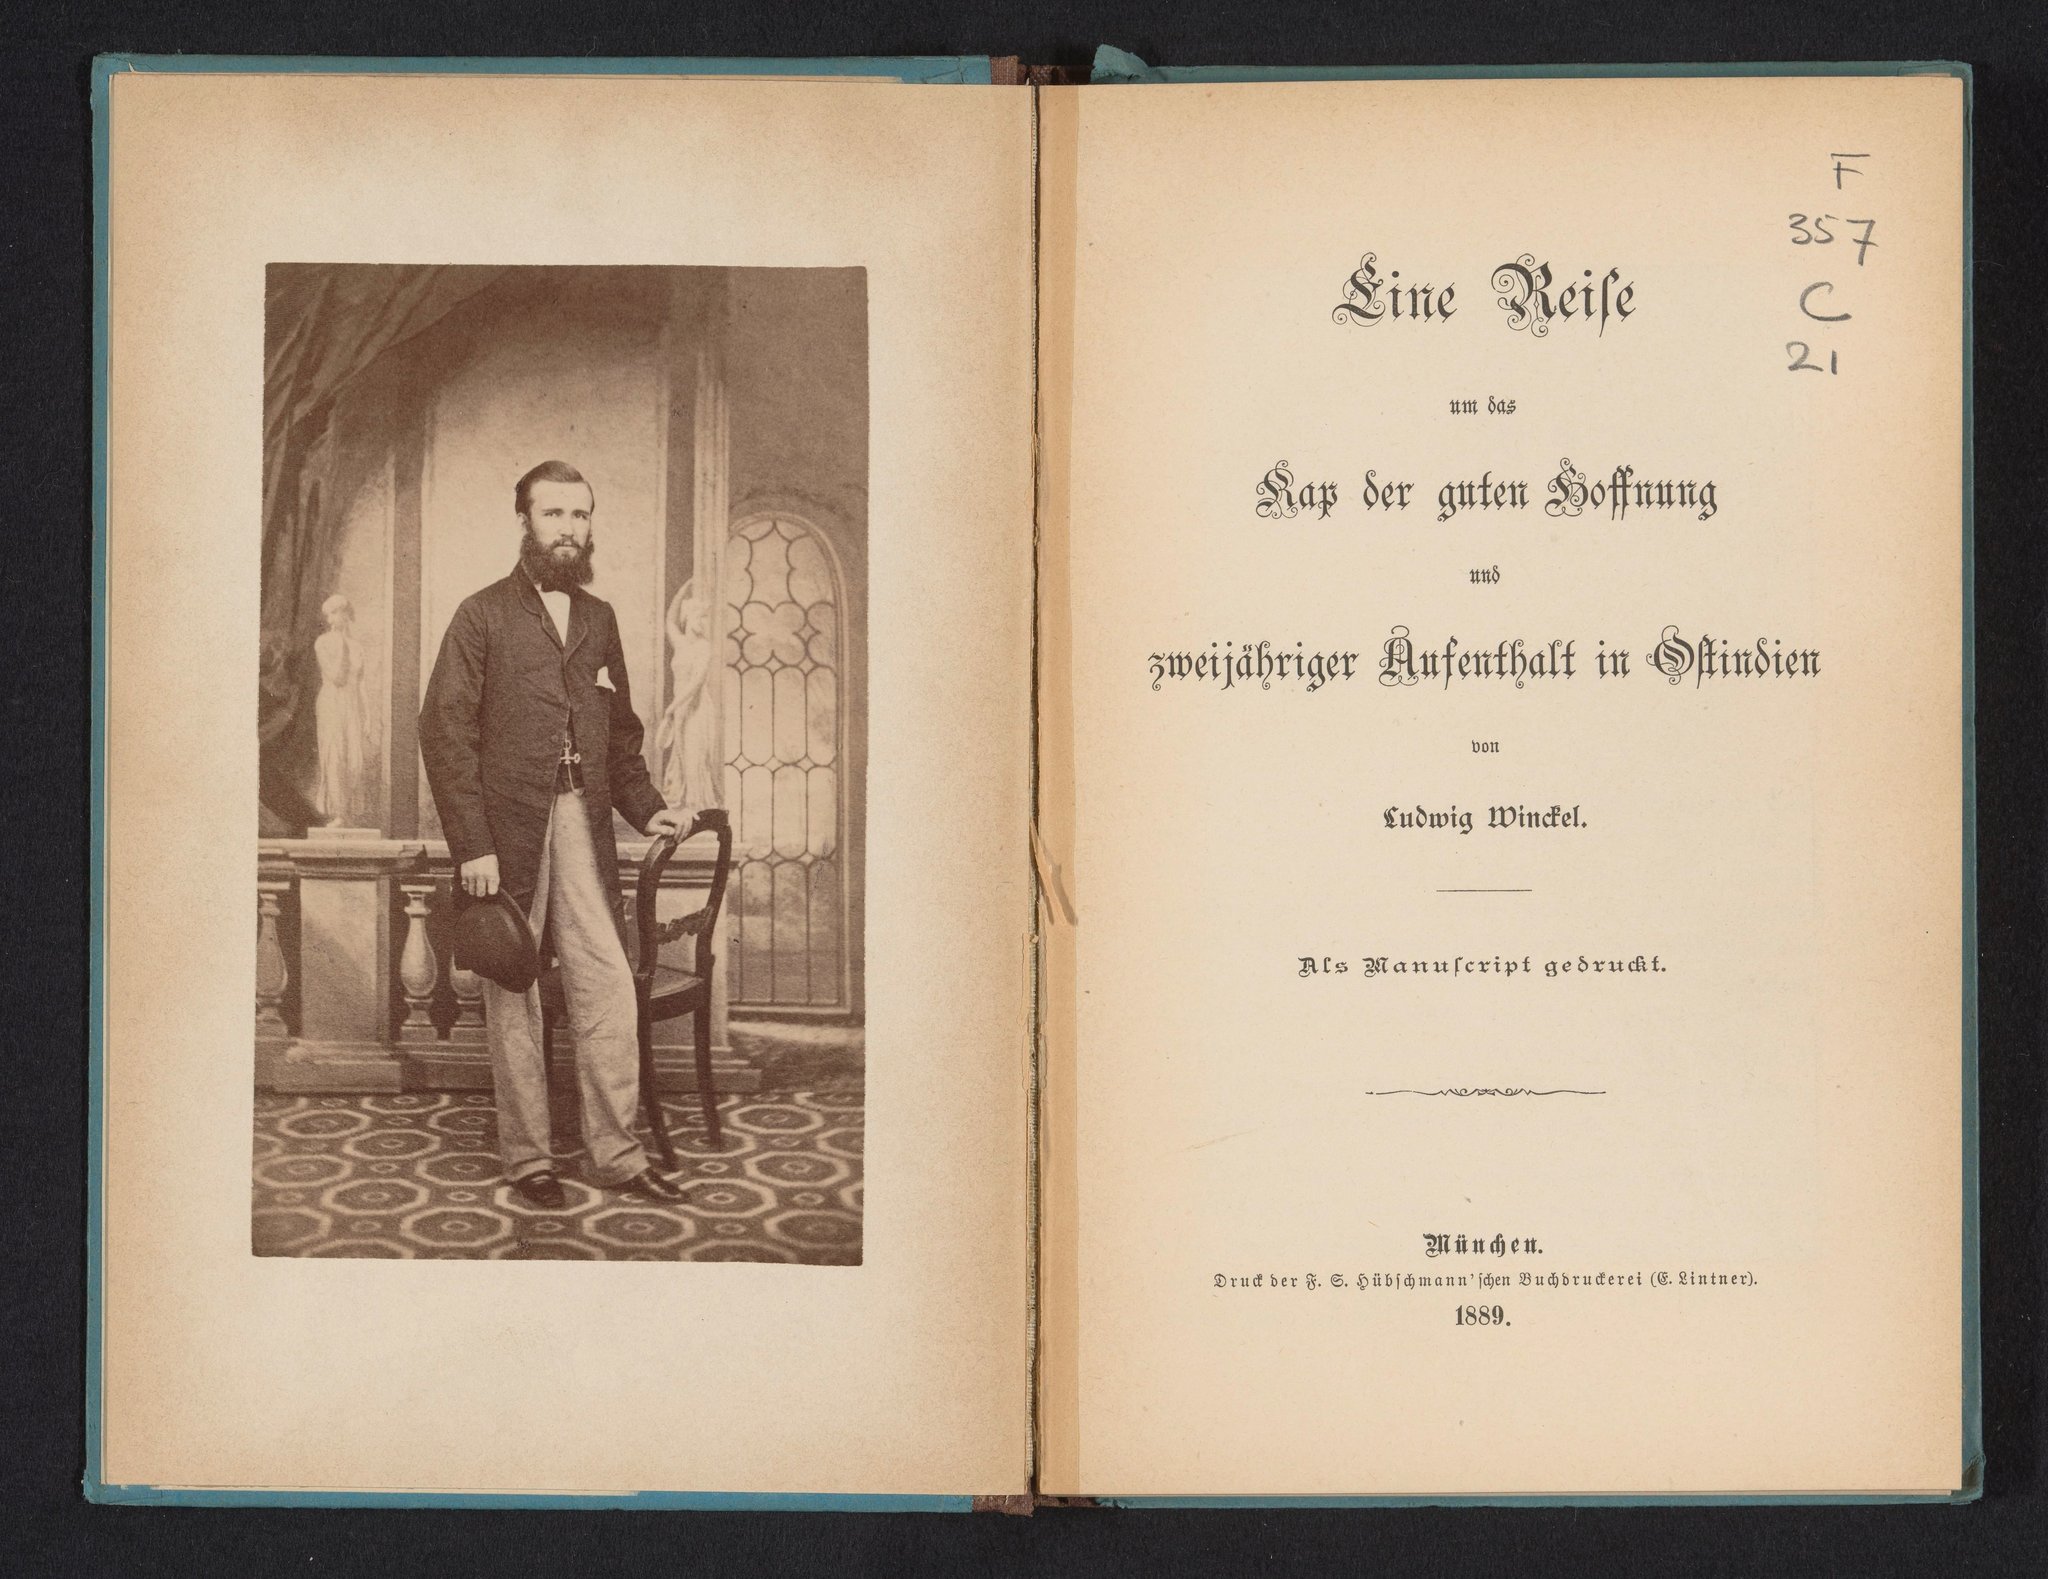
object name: page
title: Portret van Ludwig Winckel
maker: Anonymous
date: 1884-1889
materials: photographic support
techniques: albumen print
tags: ludwig winckel, portrait of a writer